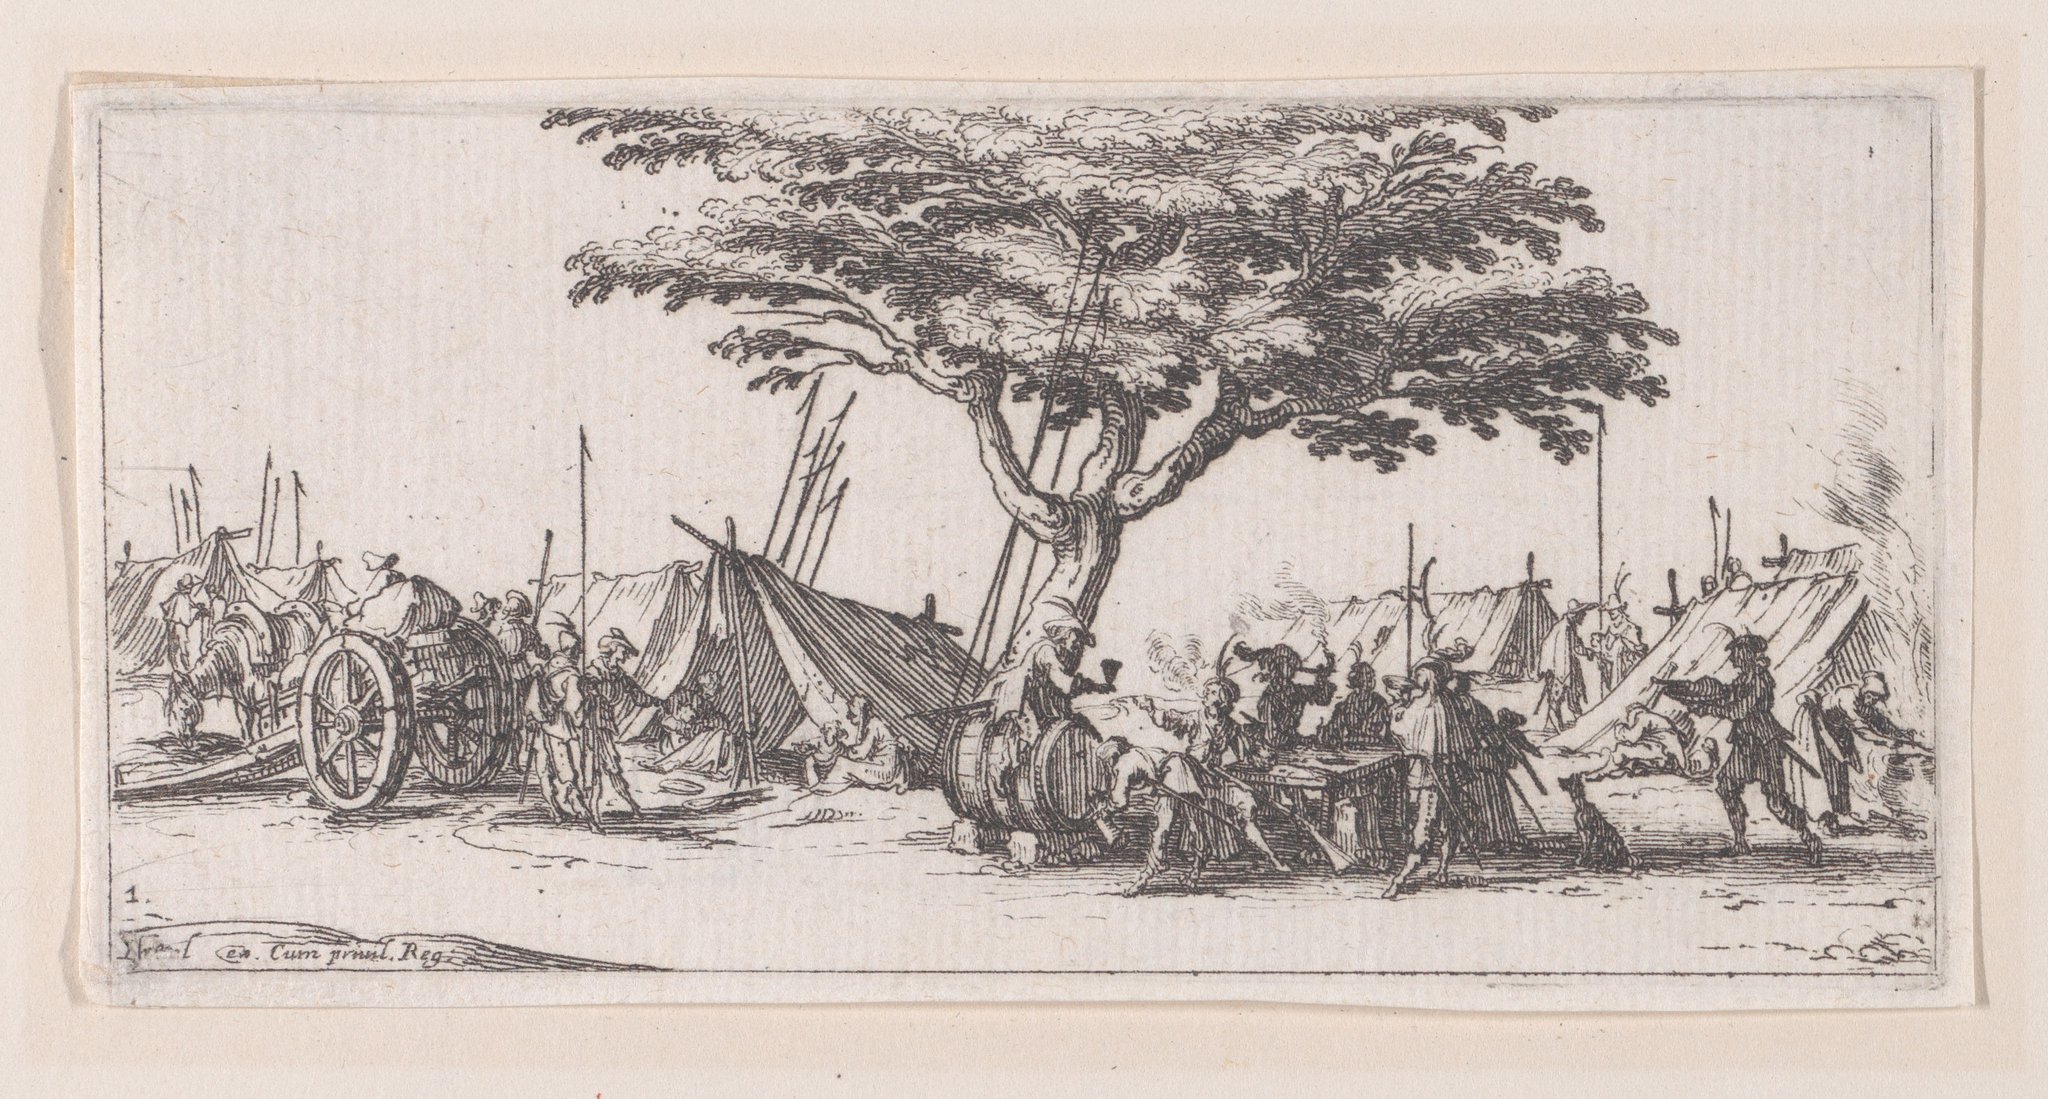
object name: print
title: Le Campement (The Camp), plate 1 from "Les Petites Misères de la Guerre" (The Little Miseries of War)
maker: jacques callot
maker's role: artist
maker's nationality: french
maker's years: 1592-1635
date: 1636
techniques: etching